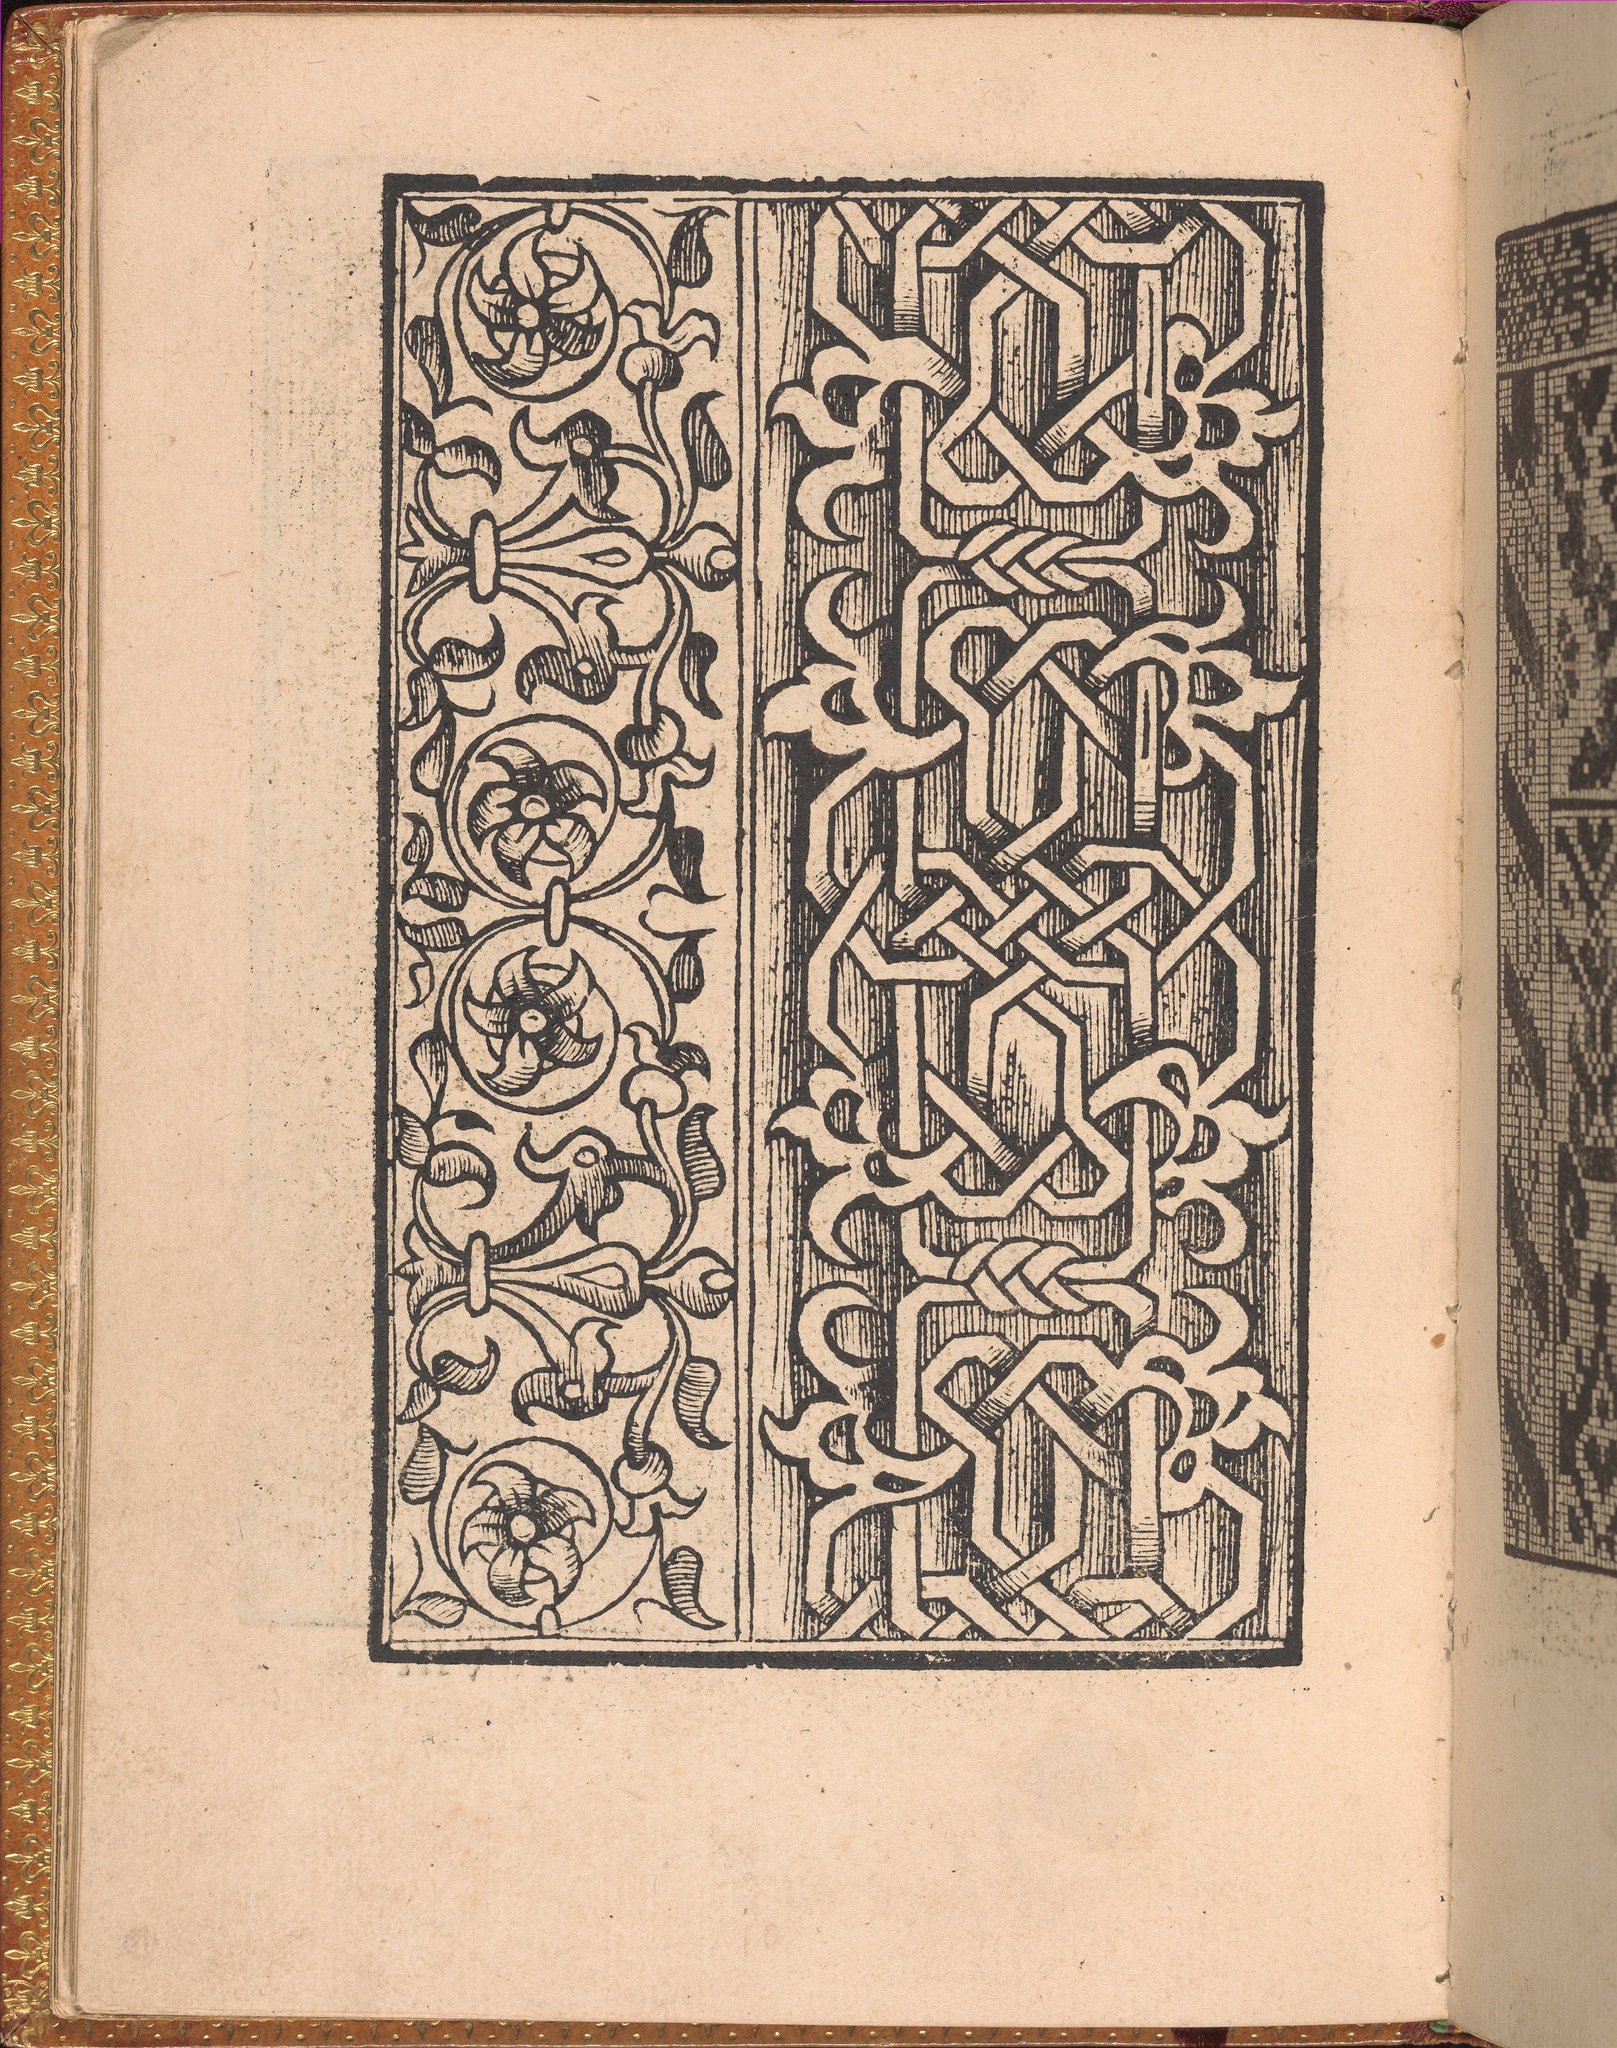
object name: book print ornament architecture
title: Convivio delle Belle Donne, page 9 (verso)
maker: nicolò zoppino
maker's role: publisher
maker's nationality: italian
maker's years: 1478-1544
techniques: woodcut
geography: italy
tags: ornament